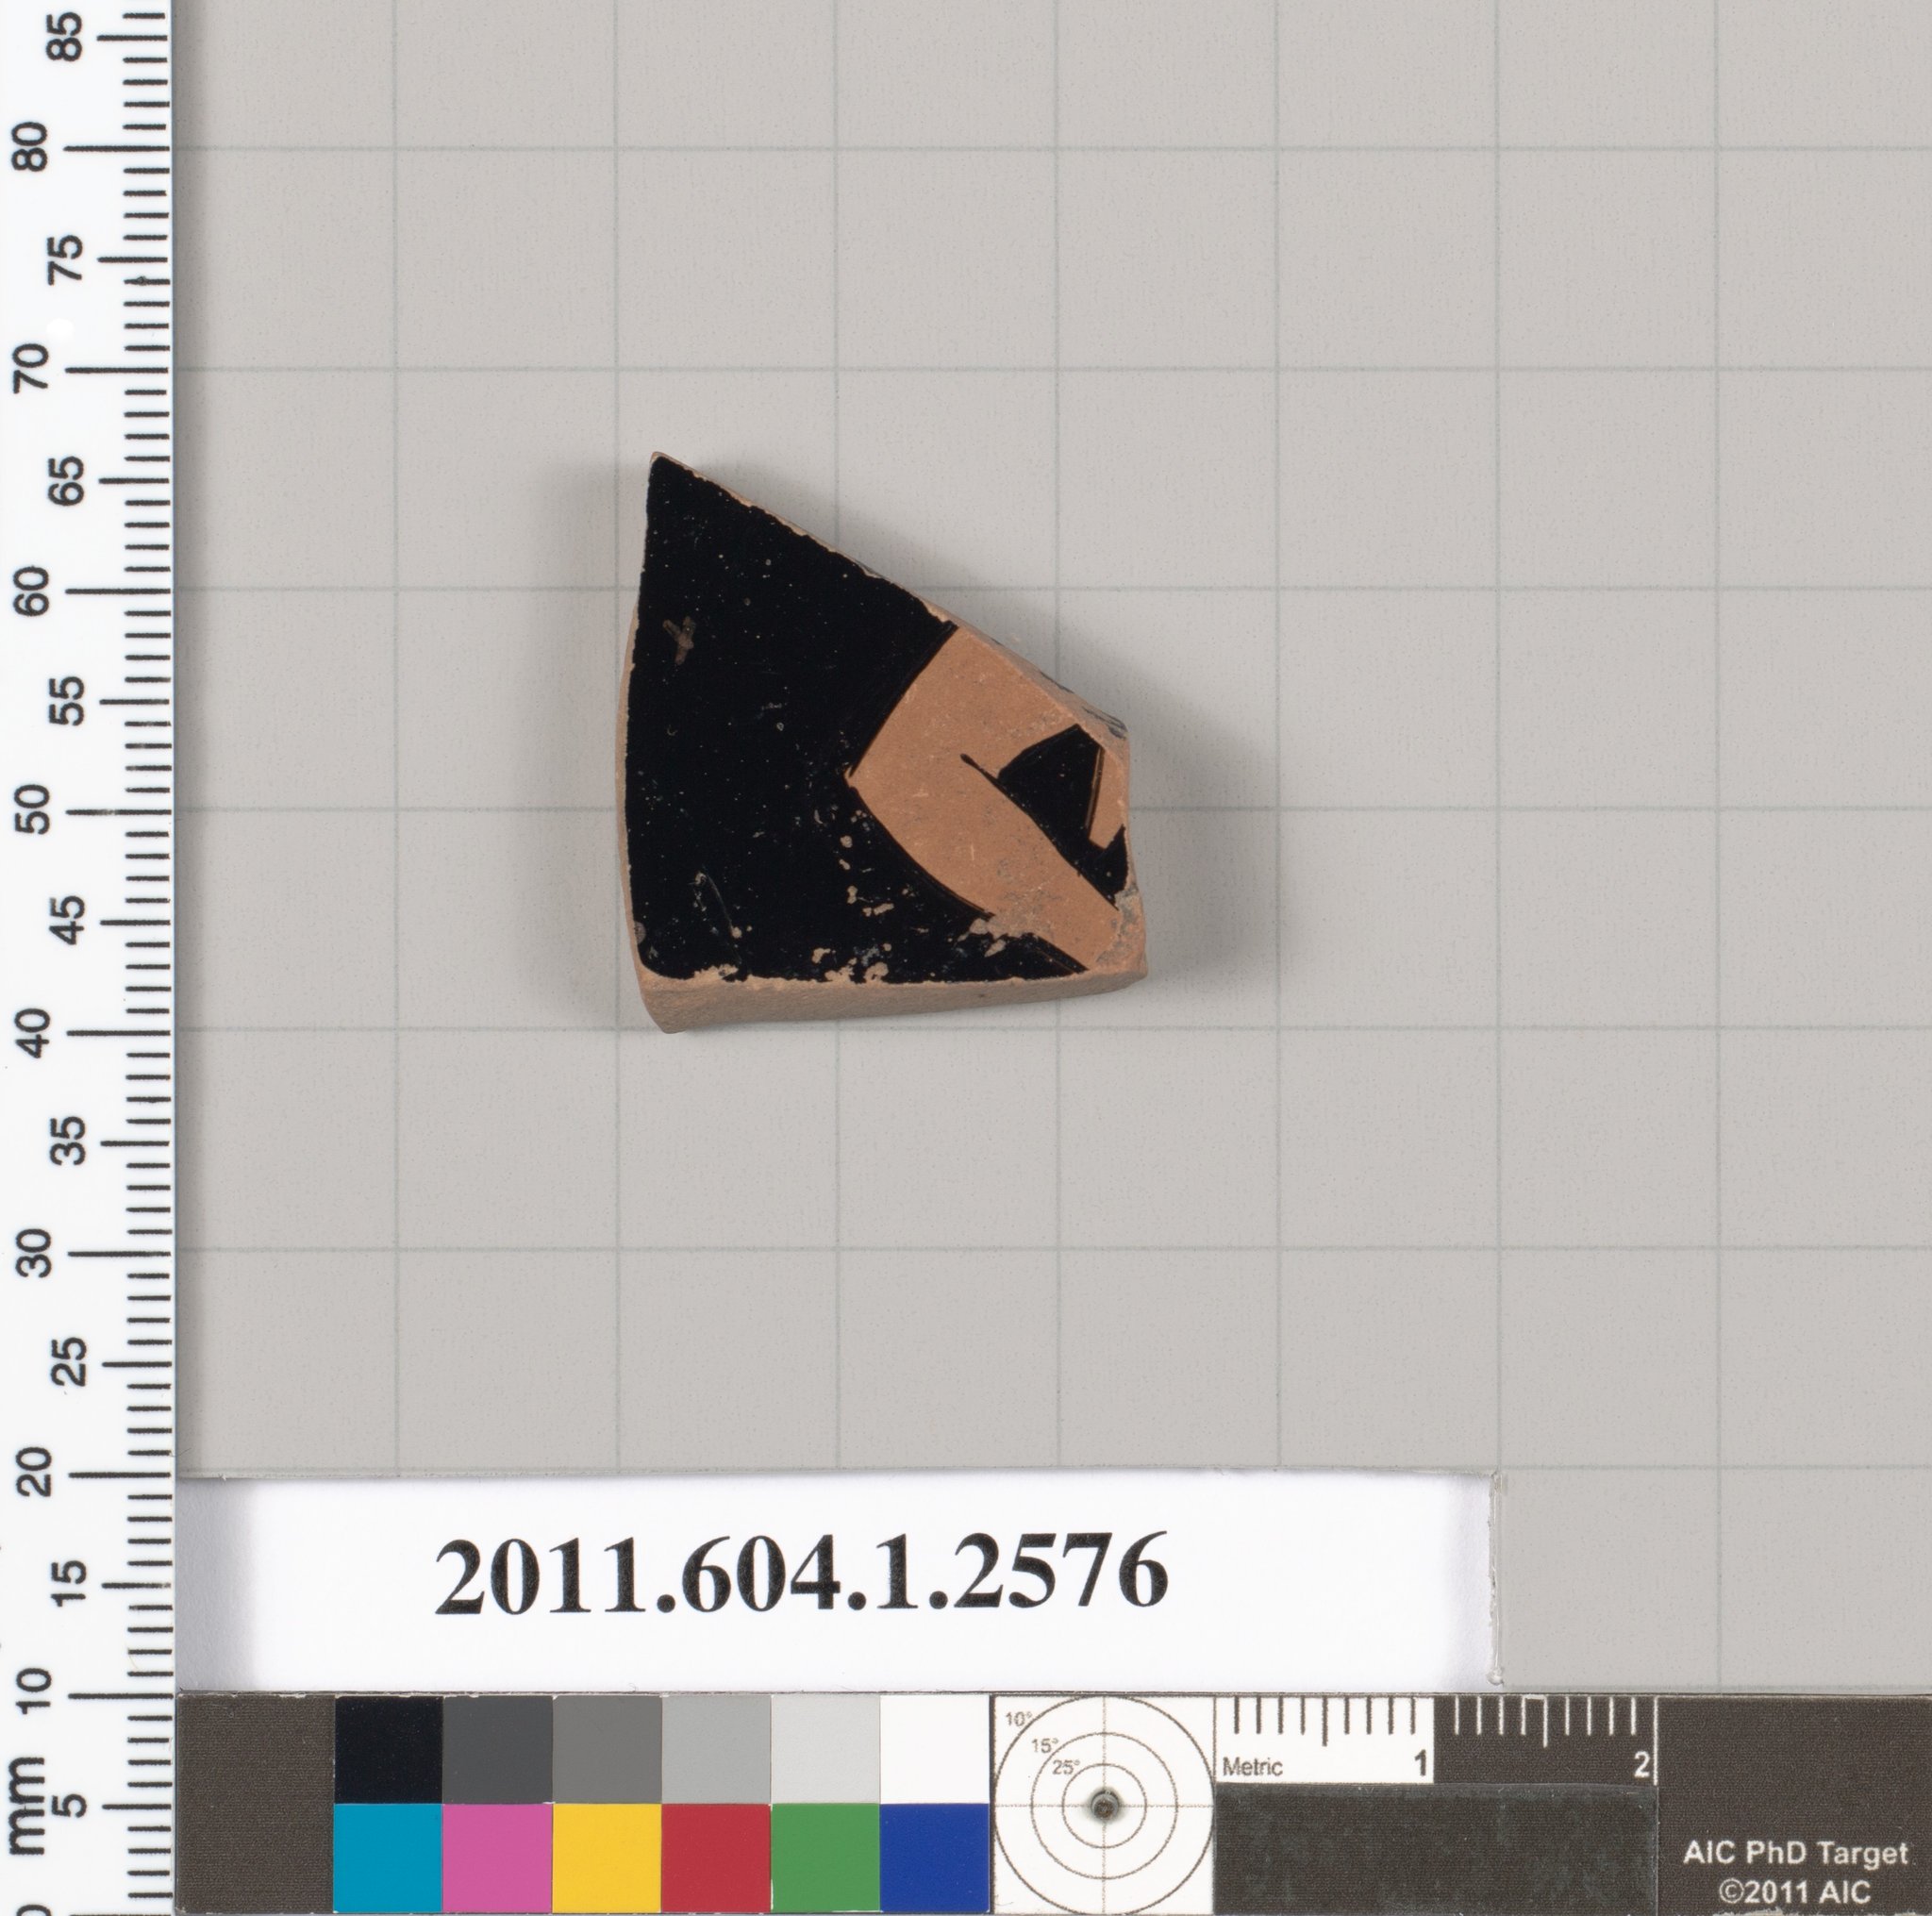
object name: kylix fragment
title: Terracotta fragment of a kylix (drinking cup)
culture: greek, attic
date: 490-480 BCE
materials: terracotta